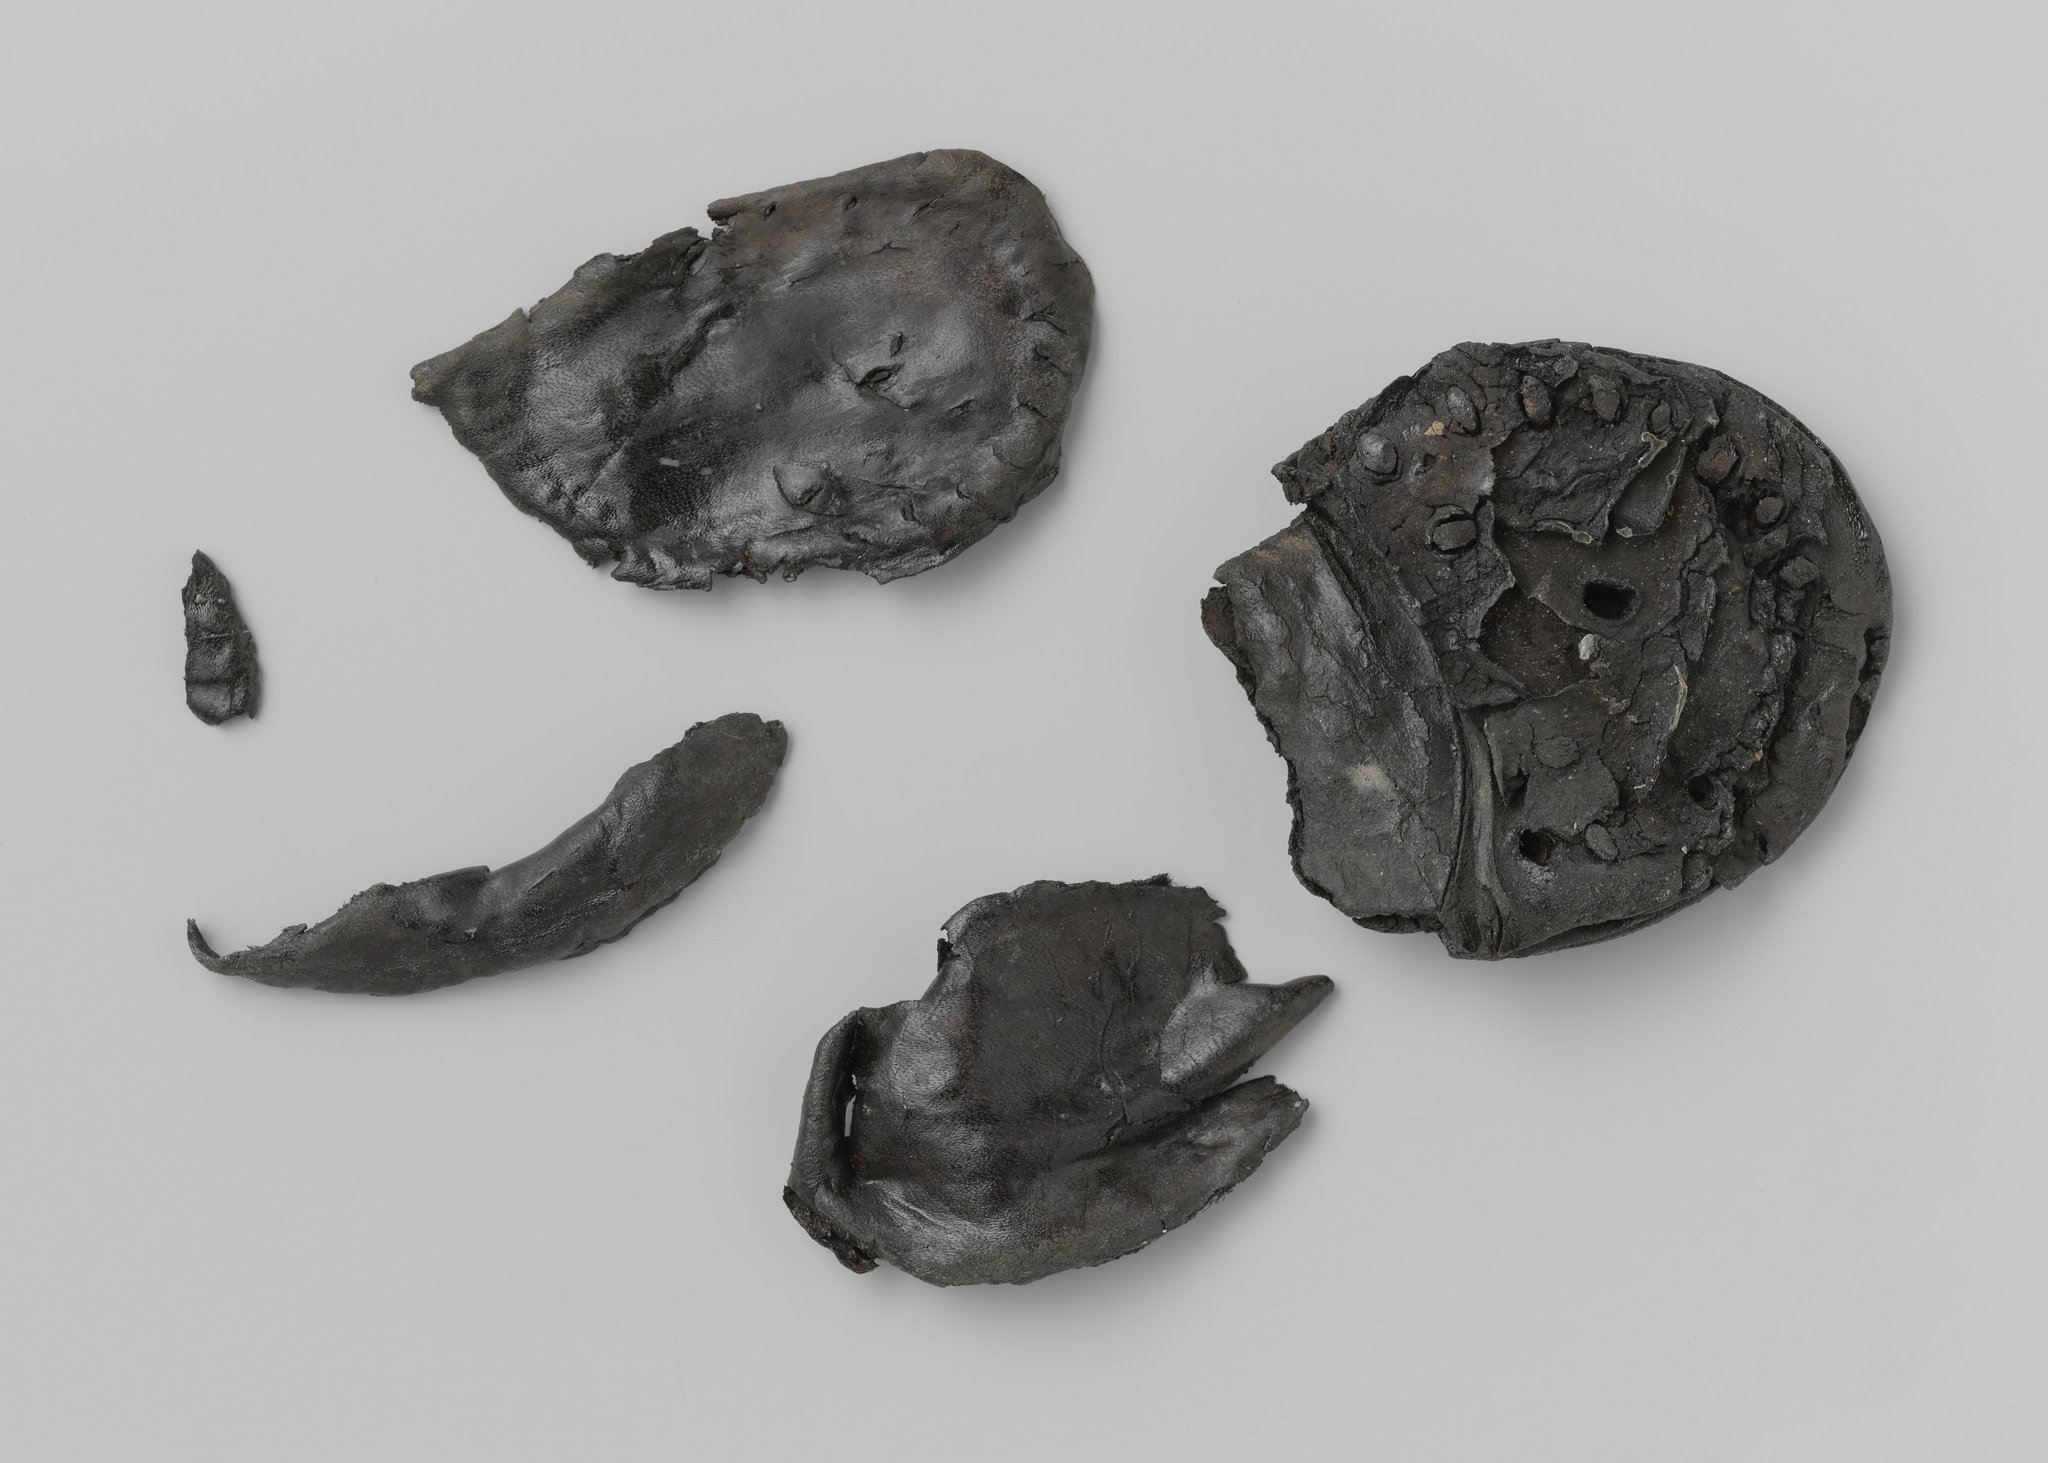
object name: sole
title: Fragmenten hakken van schoenzolen uit het wrak van de Oost-Indiëvaarder Hollandia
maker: Anonymous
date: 1700-1743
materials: leather, wood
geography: netherlands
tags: verenigde oostindische compagnie, hollandia (schip), annet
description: Shoe; fragm of heel with pins, sim. NG 1980-27H2232 dried, deformed: fragm of sole.